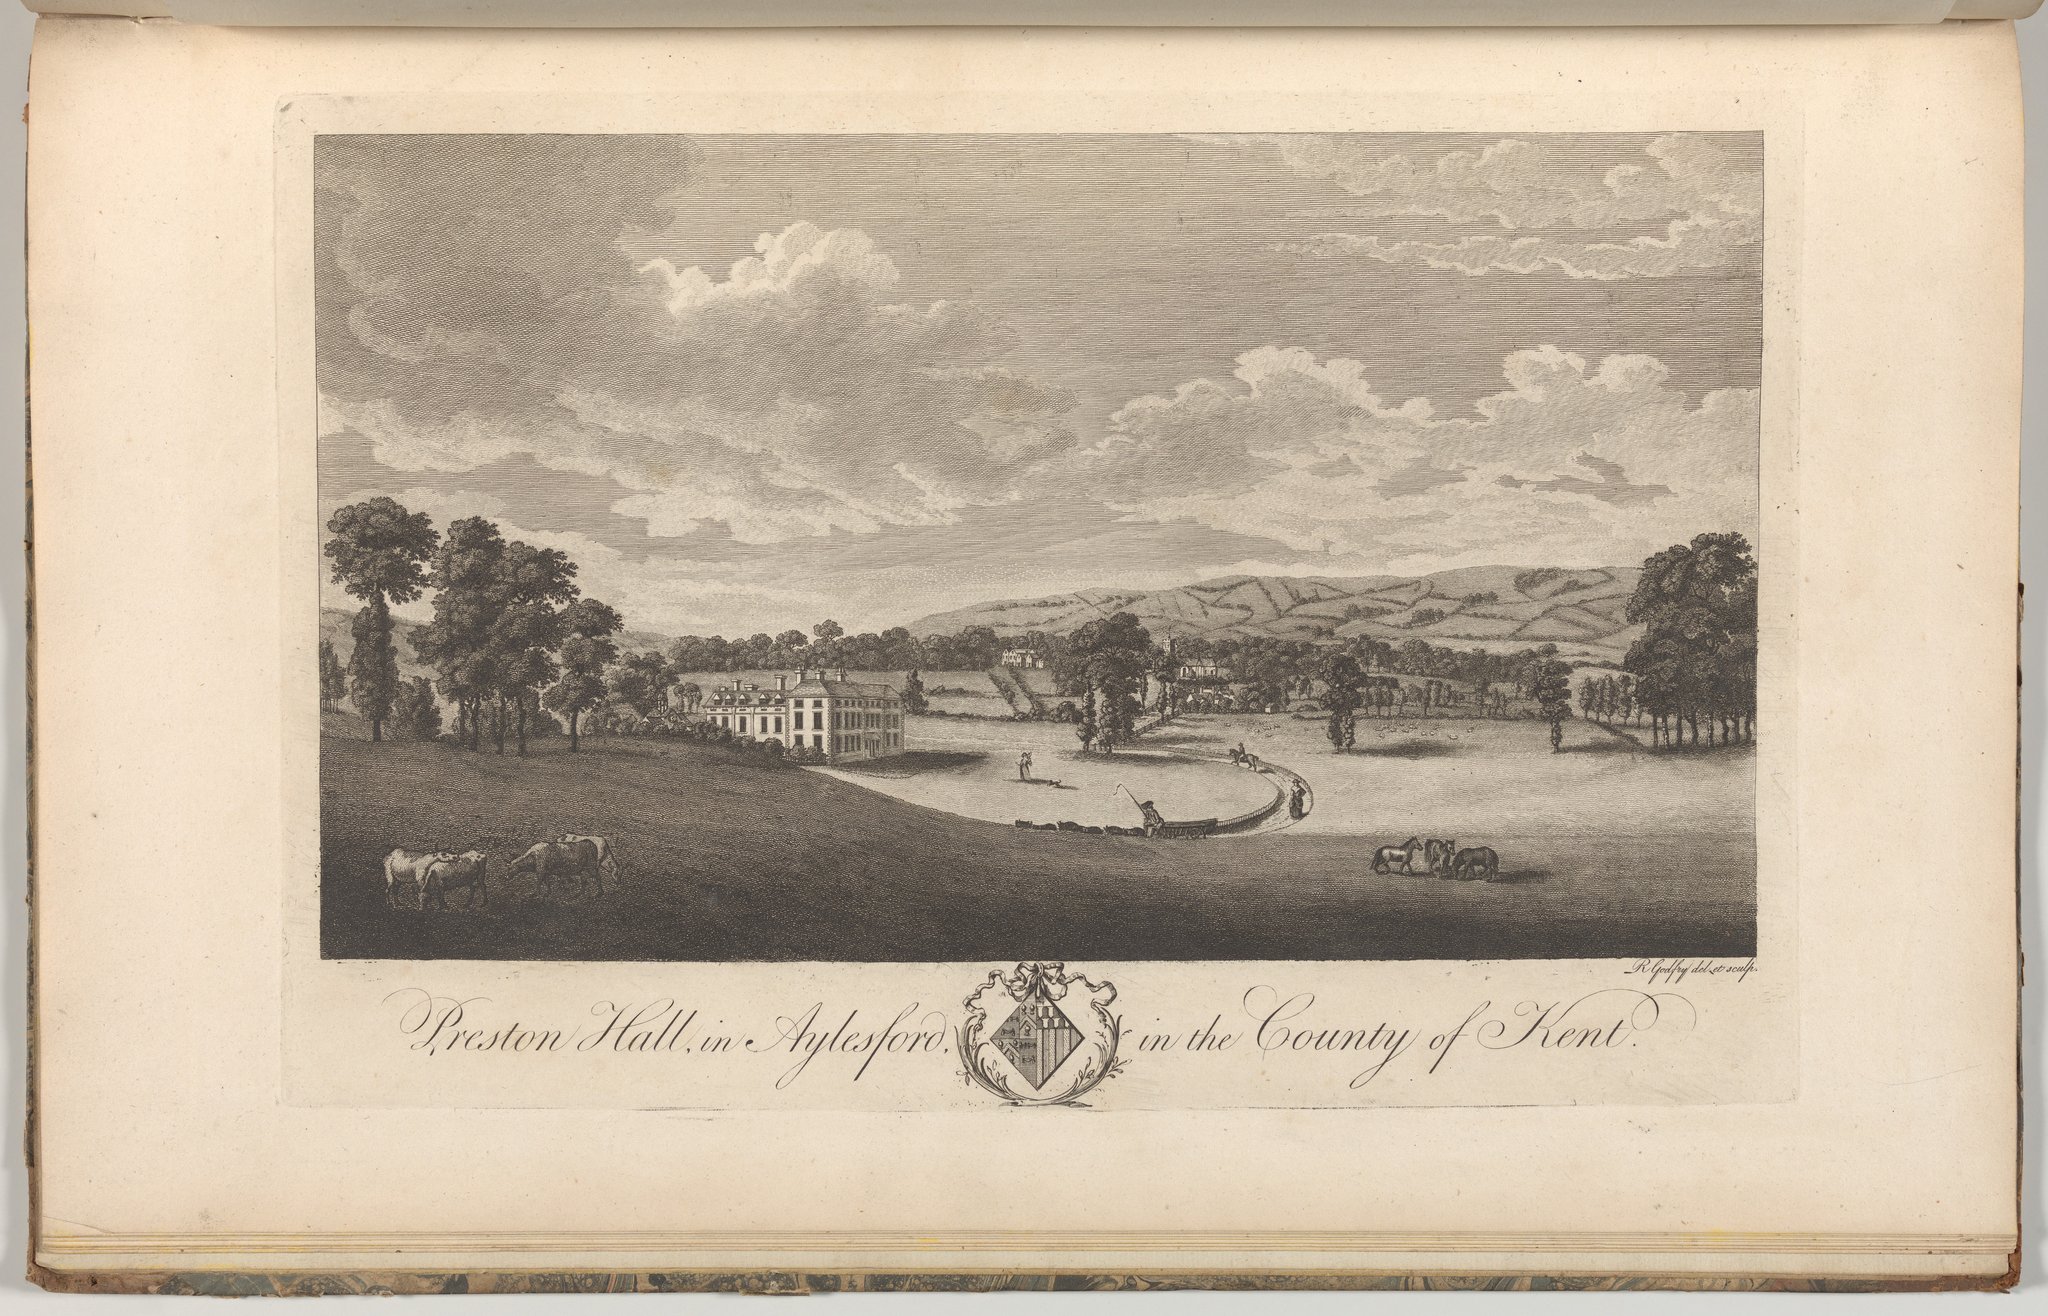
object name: print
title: Merenorth House, in the County of Kent, from Edward Hasted's "The History and Topographical Survey of the County of Kent", vols. 1-3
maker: richard bernard godfrey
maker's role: artist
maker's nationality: british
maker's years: 1728-1795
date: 1777-1790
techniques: engraving, etching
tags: animals,buildings,landscapes